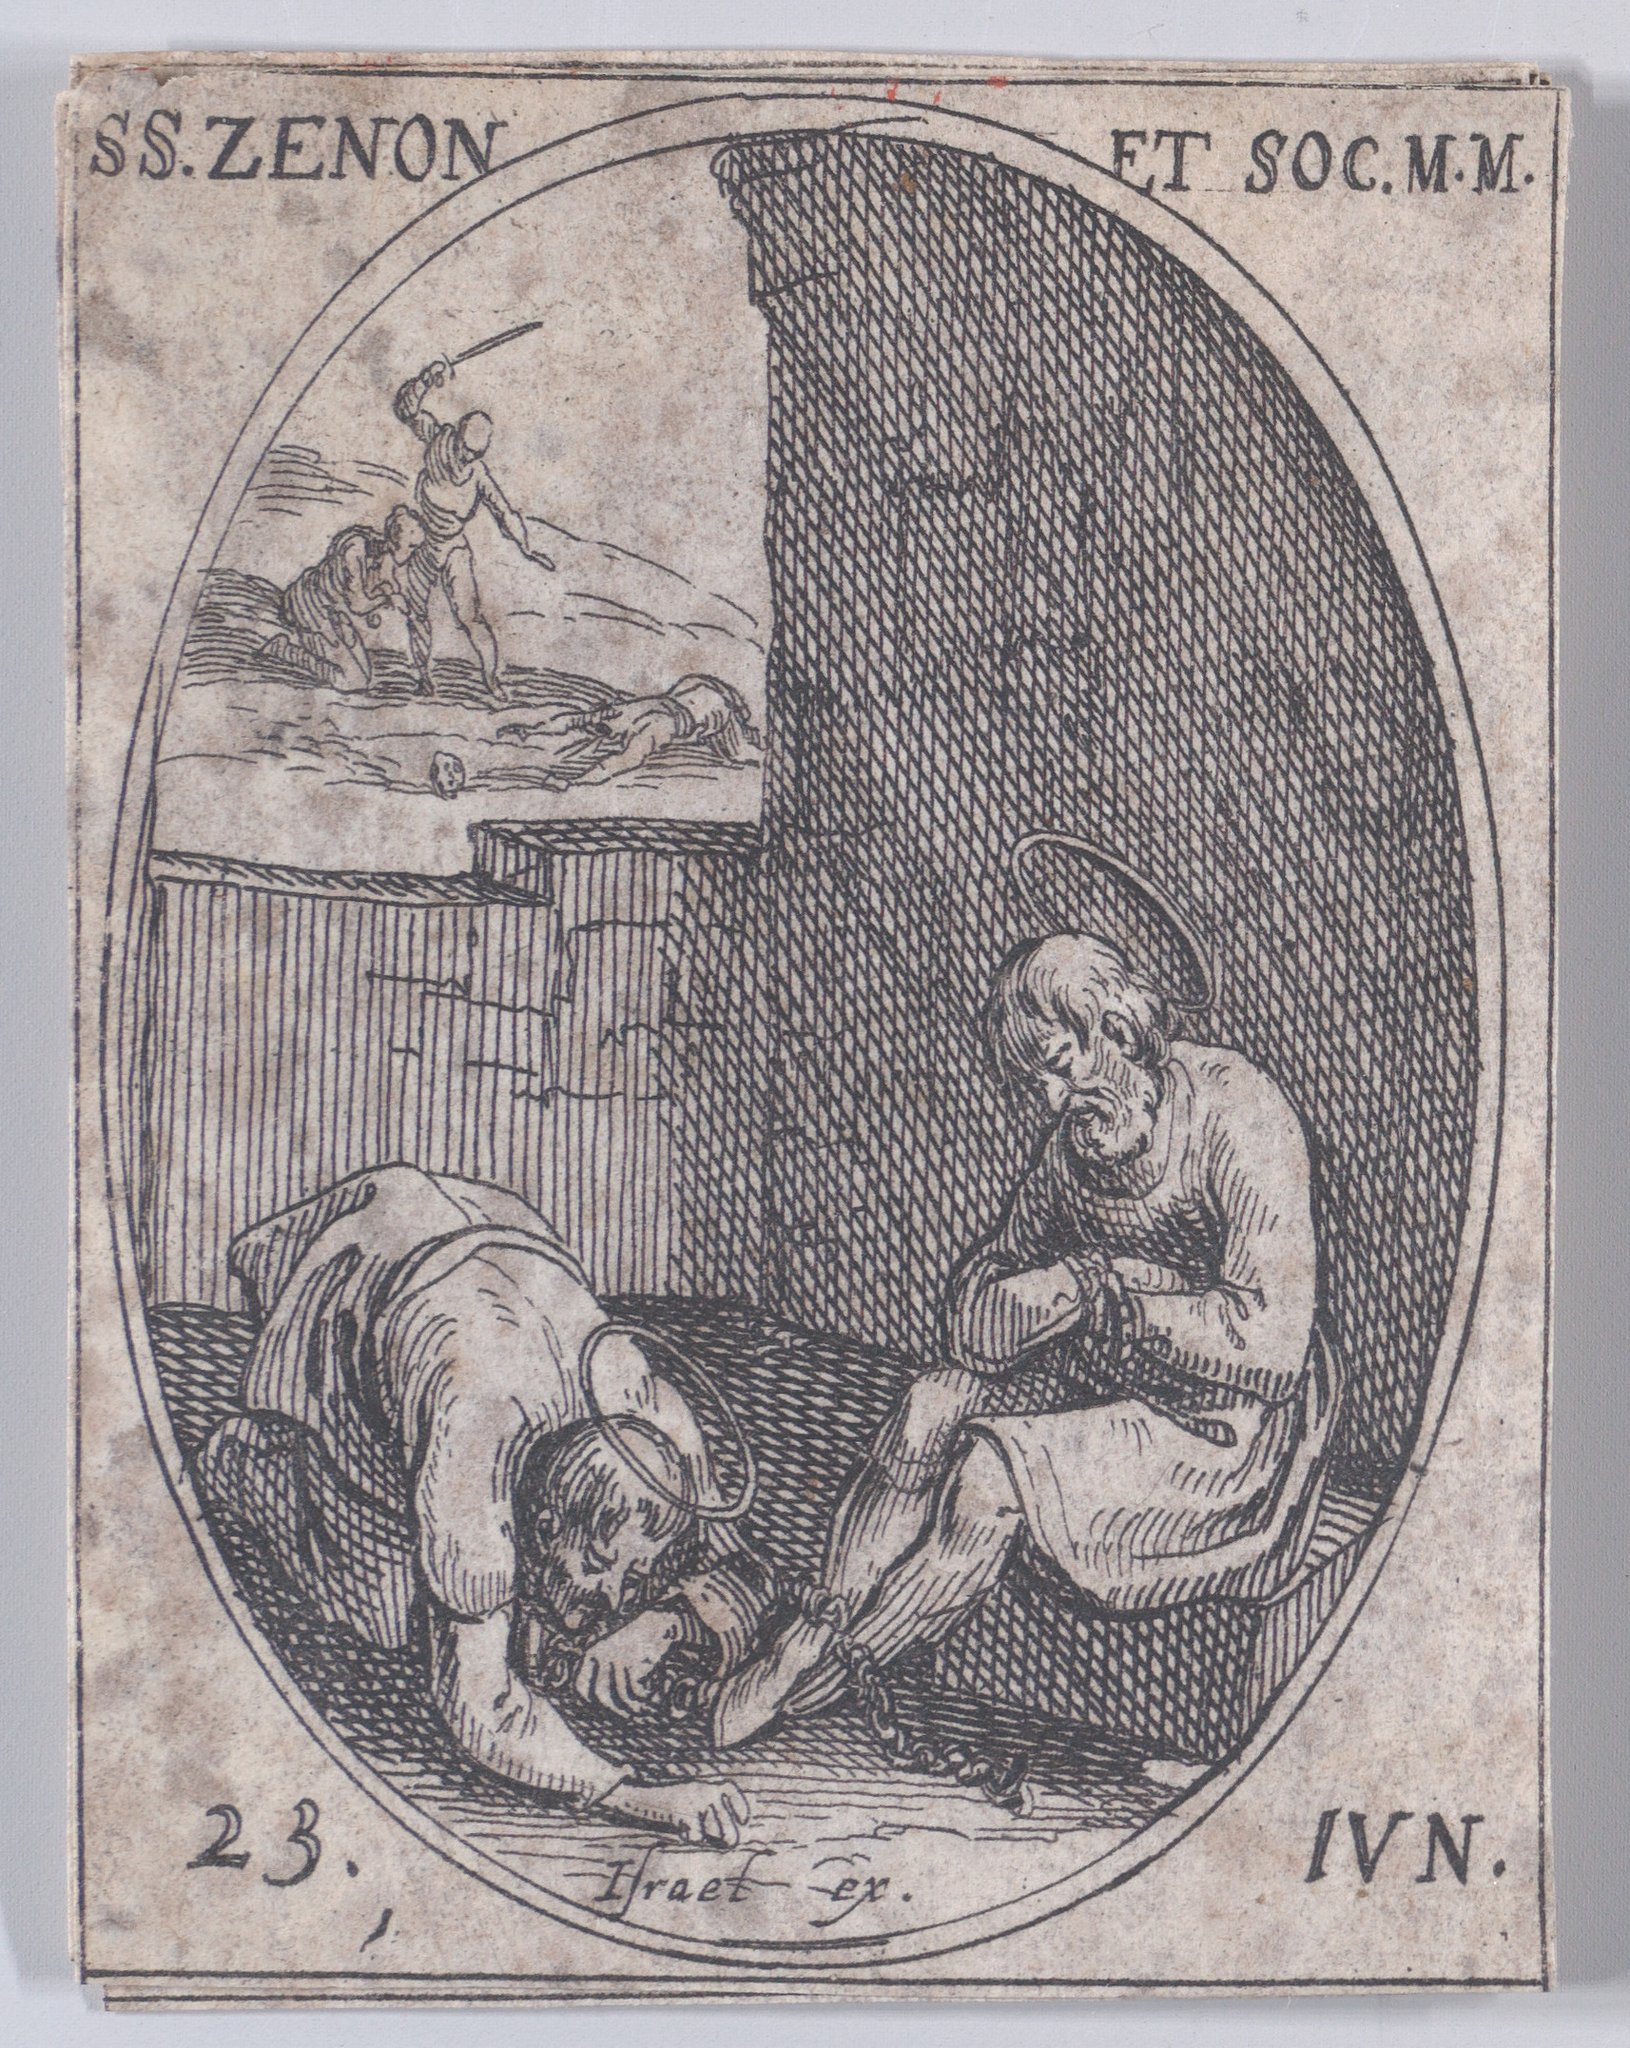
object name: print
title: S. Zenon et Ses Compagnons (St. Zeno and His Companions), June 23rd, from "Les Images De Tous Les Saincts et Saintes de L'Année" (Images of All of the Saints and Religious Events of the Year)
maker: jacques callot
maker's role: artist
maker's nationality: french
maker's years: 1592-1635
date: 1636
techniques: etching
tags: men,saints